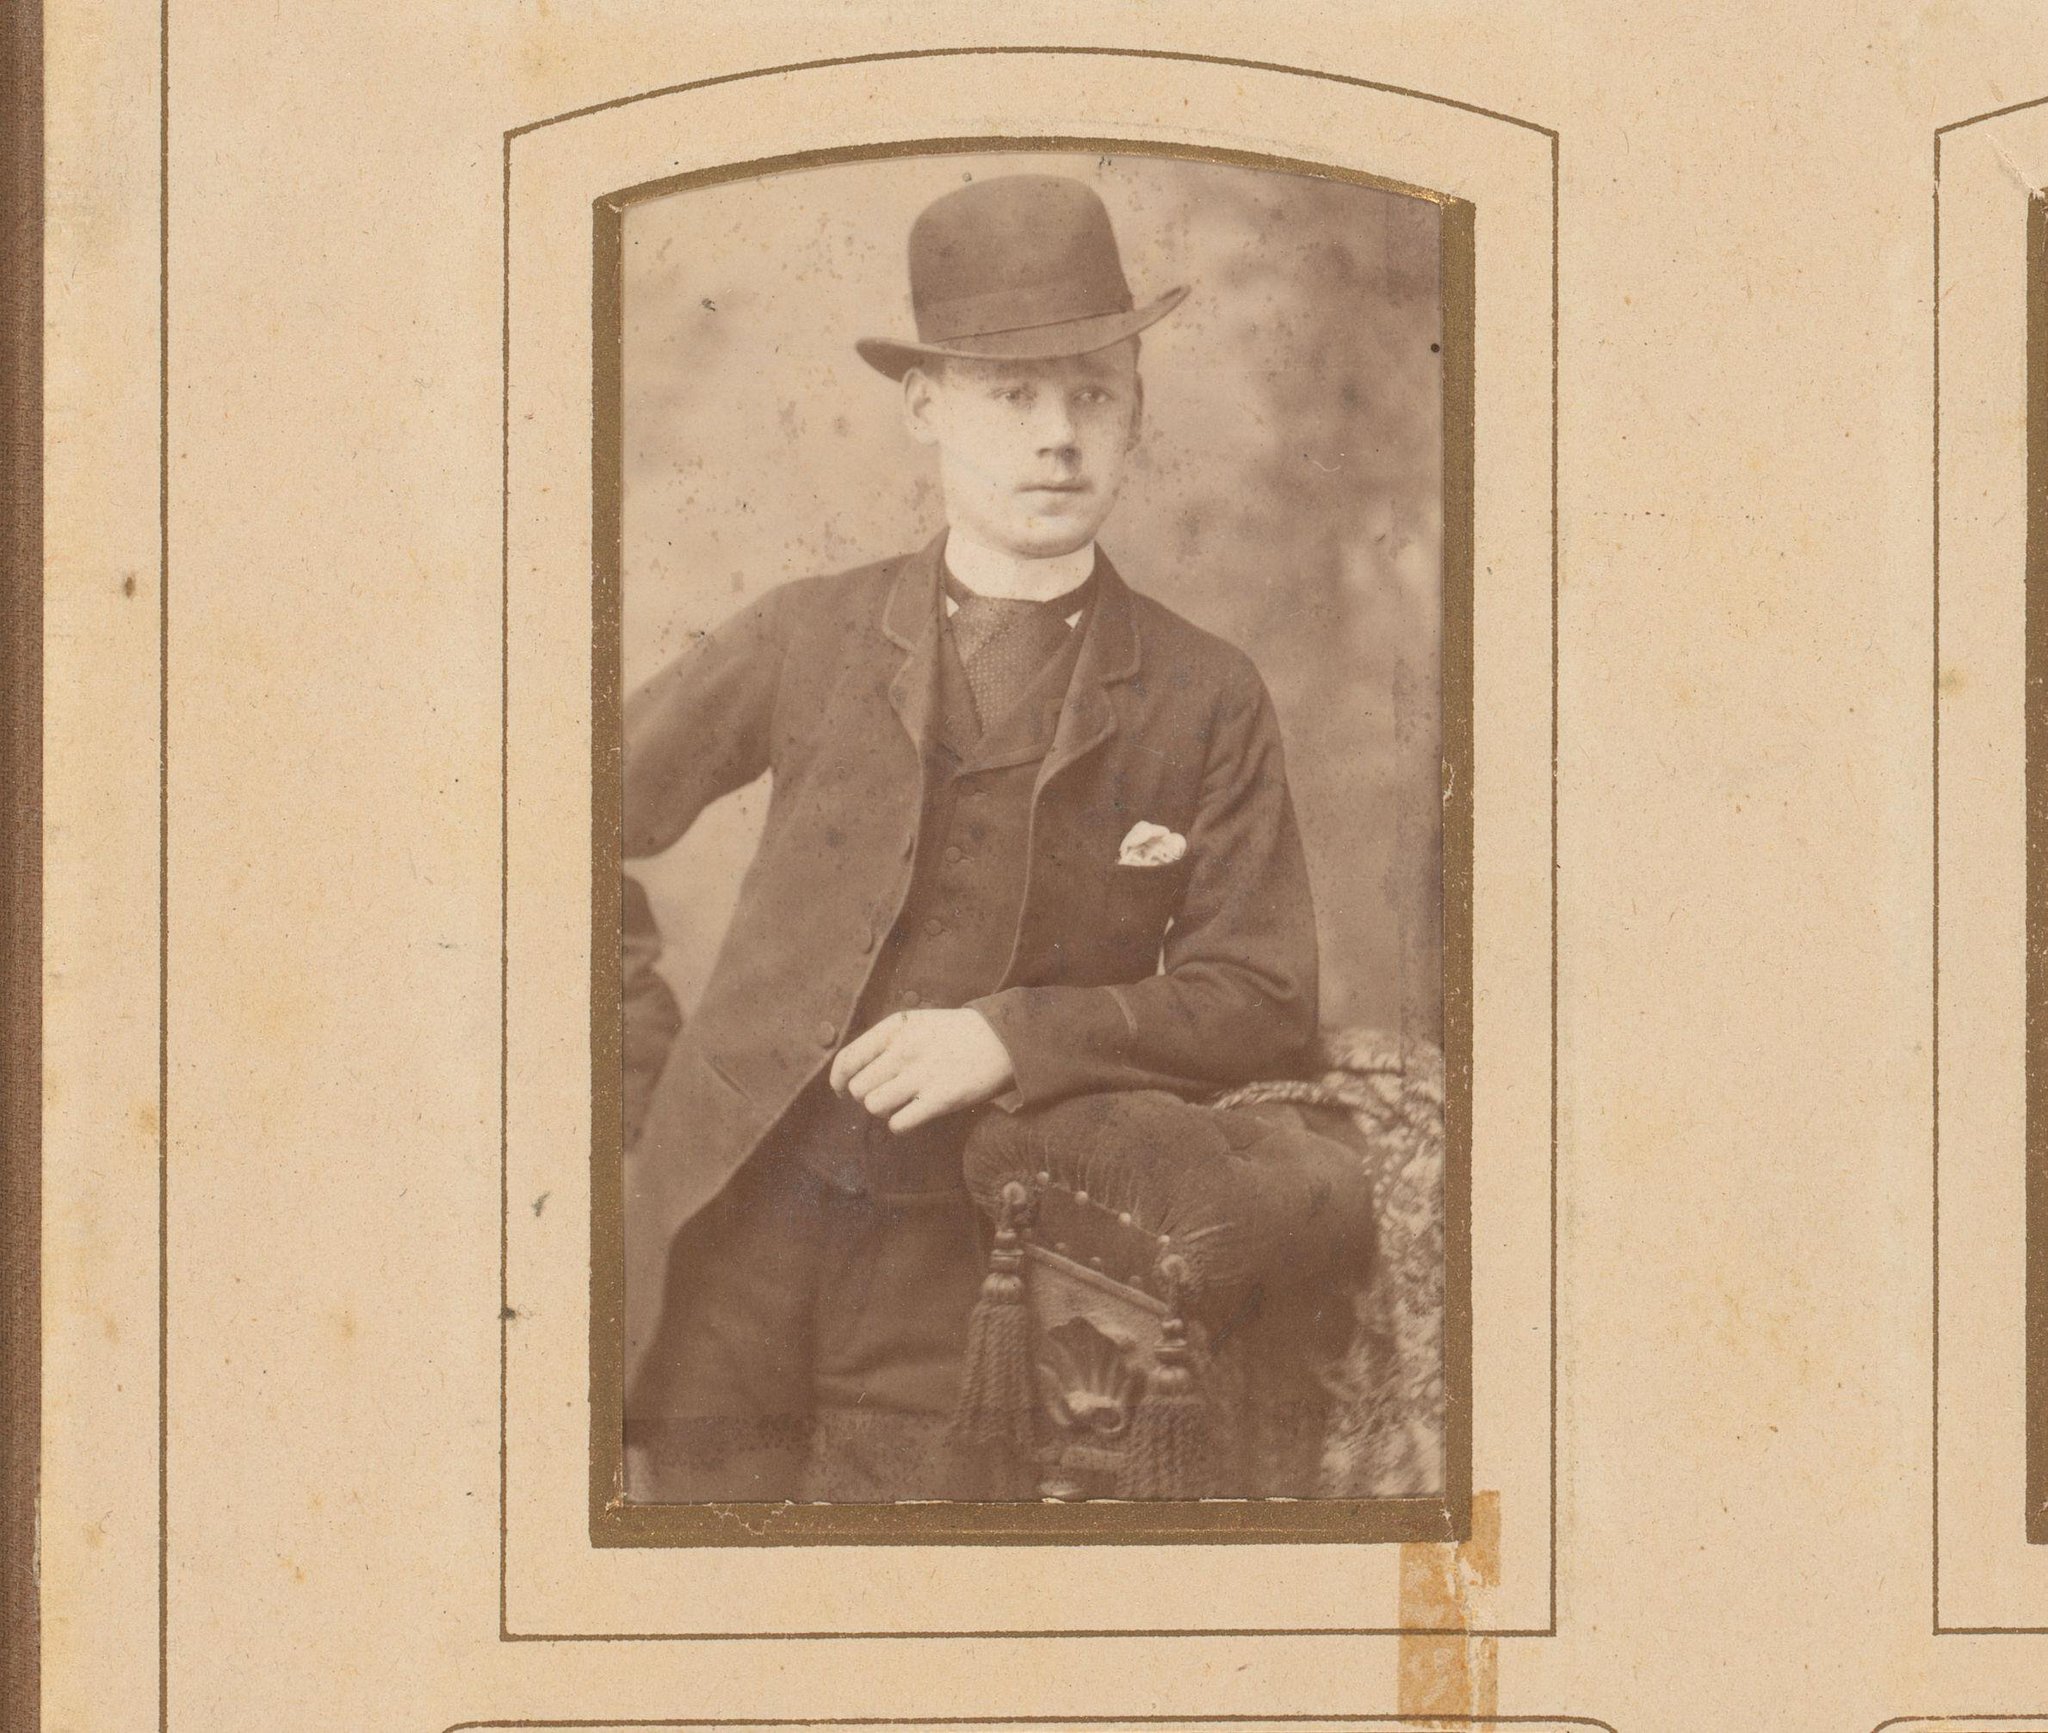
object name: album leaf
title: Portret van een staande jonge man met bolhoed, leunend op de leuning van een stoel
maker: william george henry wright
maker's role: fotograaf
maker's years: 1860-1915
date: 1885-1900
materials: cardboard, photographic support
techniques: albumen print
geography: london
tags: standing figure, head-gear: bowler hat, historical persons, youth, adolescent, chair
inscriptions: inscription: ‘Photographic studios/ W. Wright/ 188 190/ Bethnal, Green Rd./ 98, Cheapside,/ 81, High St. Whitechapel,/ 10 Upper Street, Islington,/ 71, Green Lanes, Stoke Newington./ London.’